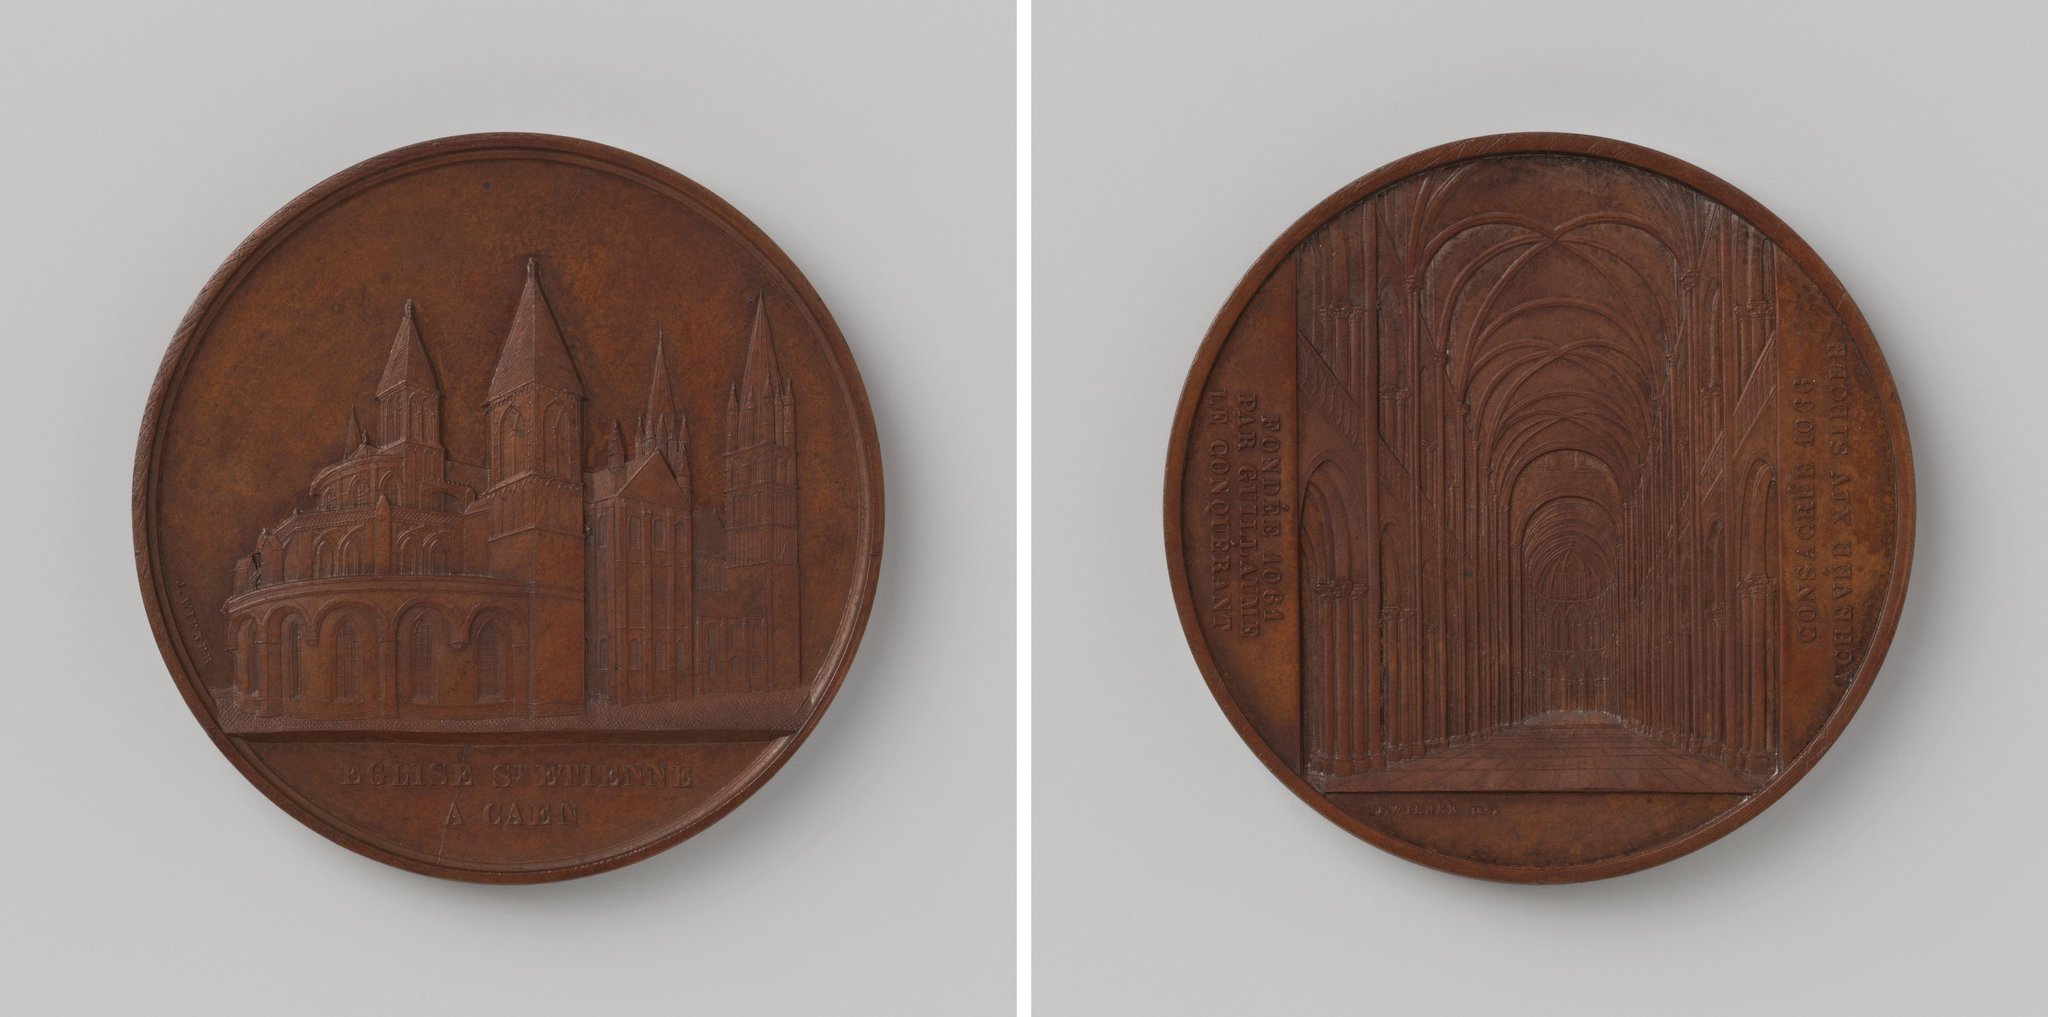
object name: history medal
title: St. Etienne te Caen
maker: jacob wiener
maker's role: medailleur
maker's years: 1815-1899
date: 1862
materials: bronze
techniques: striking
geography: brussels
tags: saint-étienne, abdijkerk